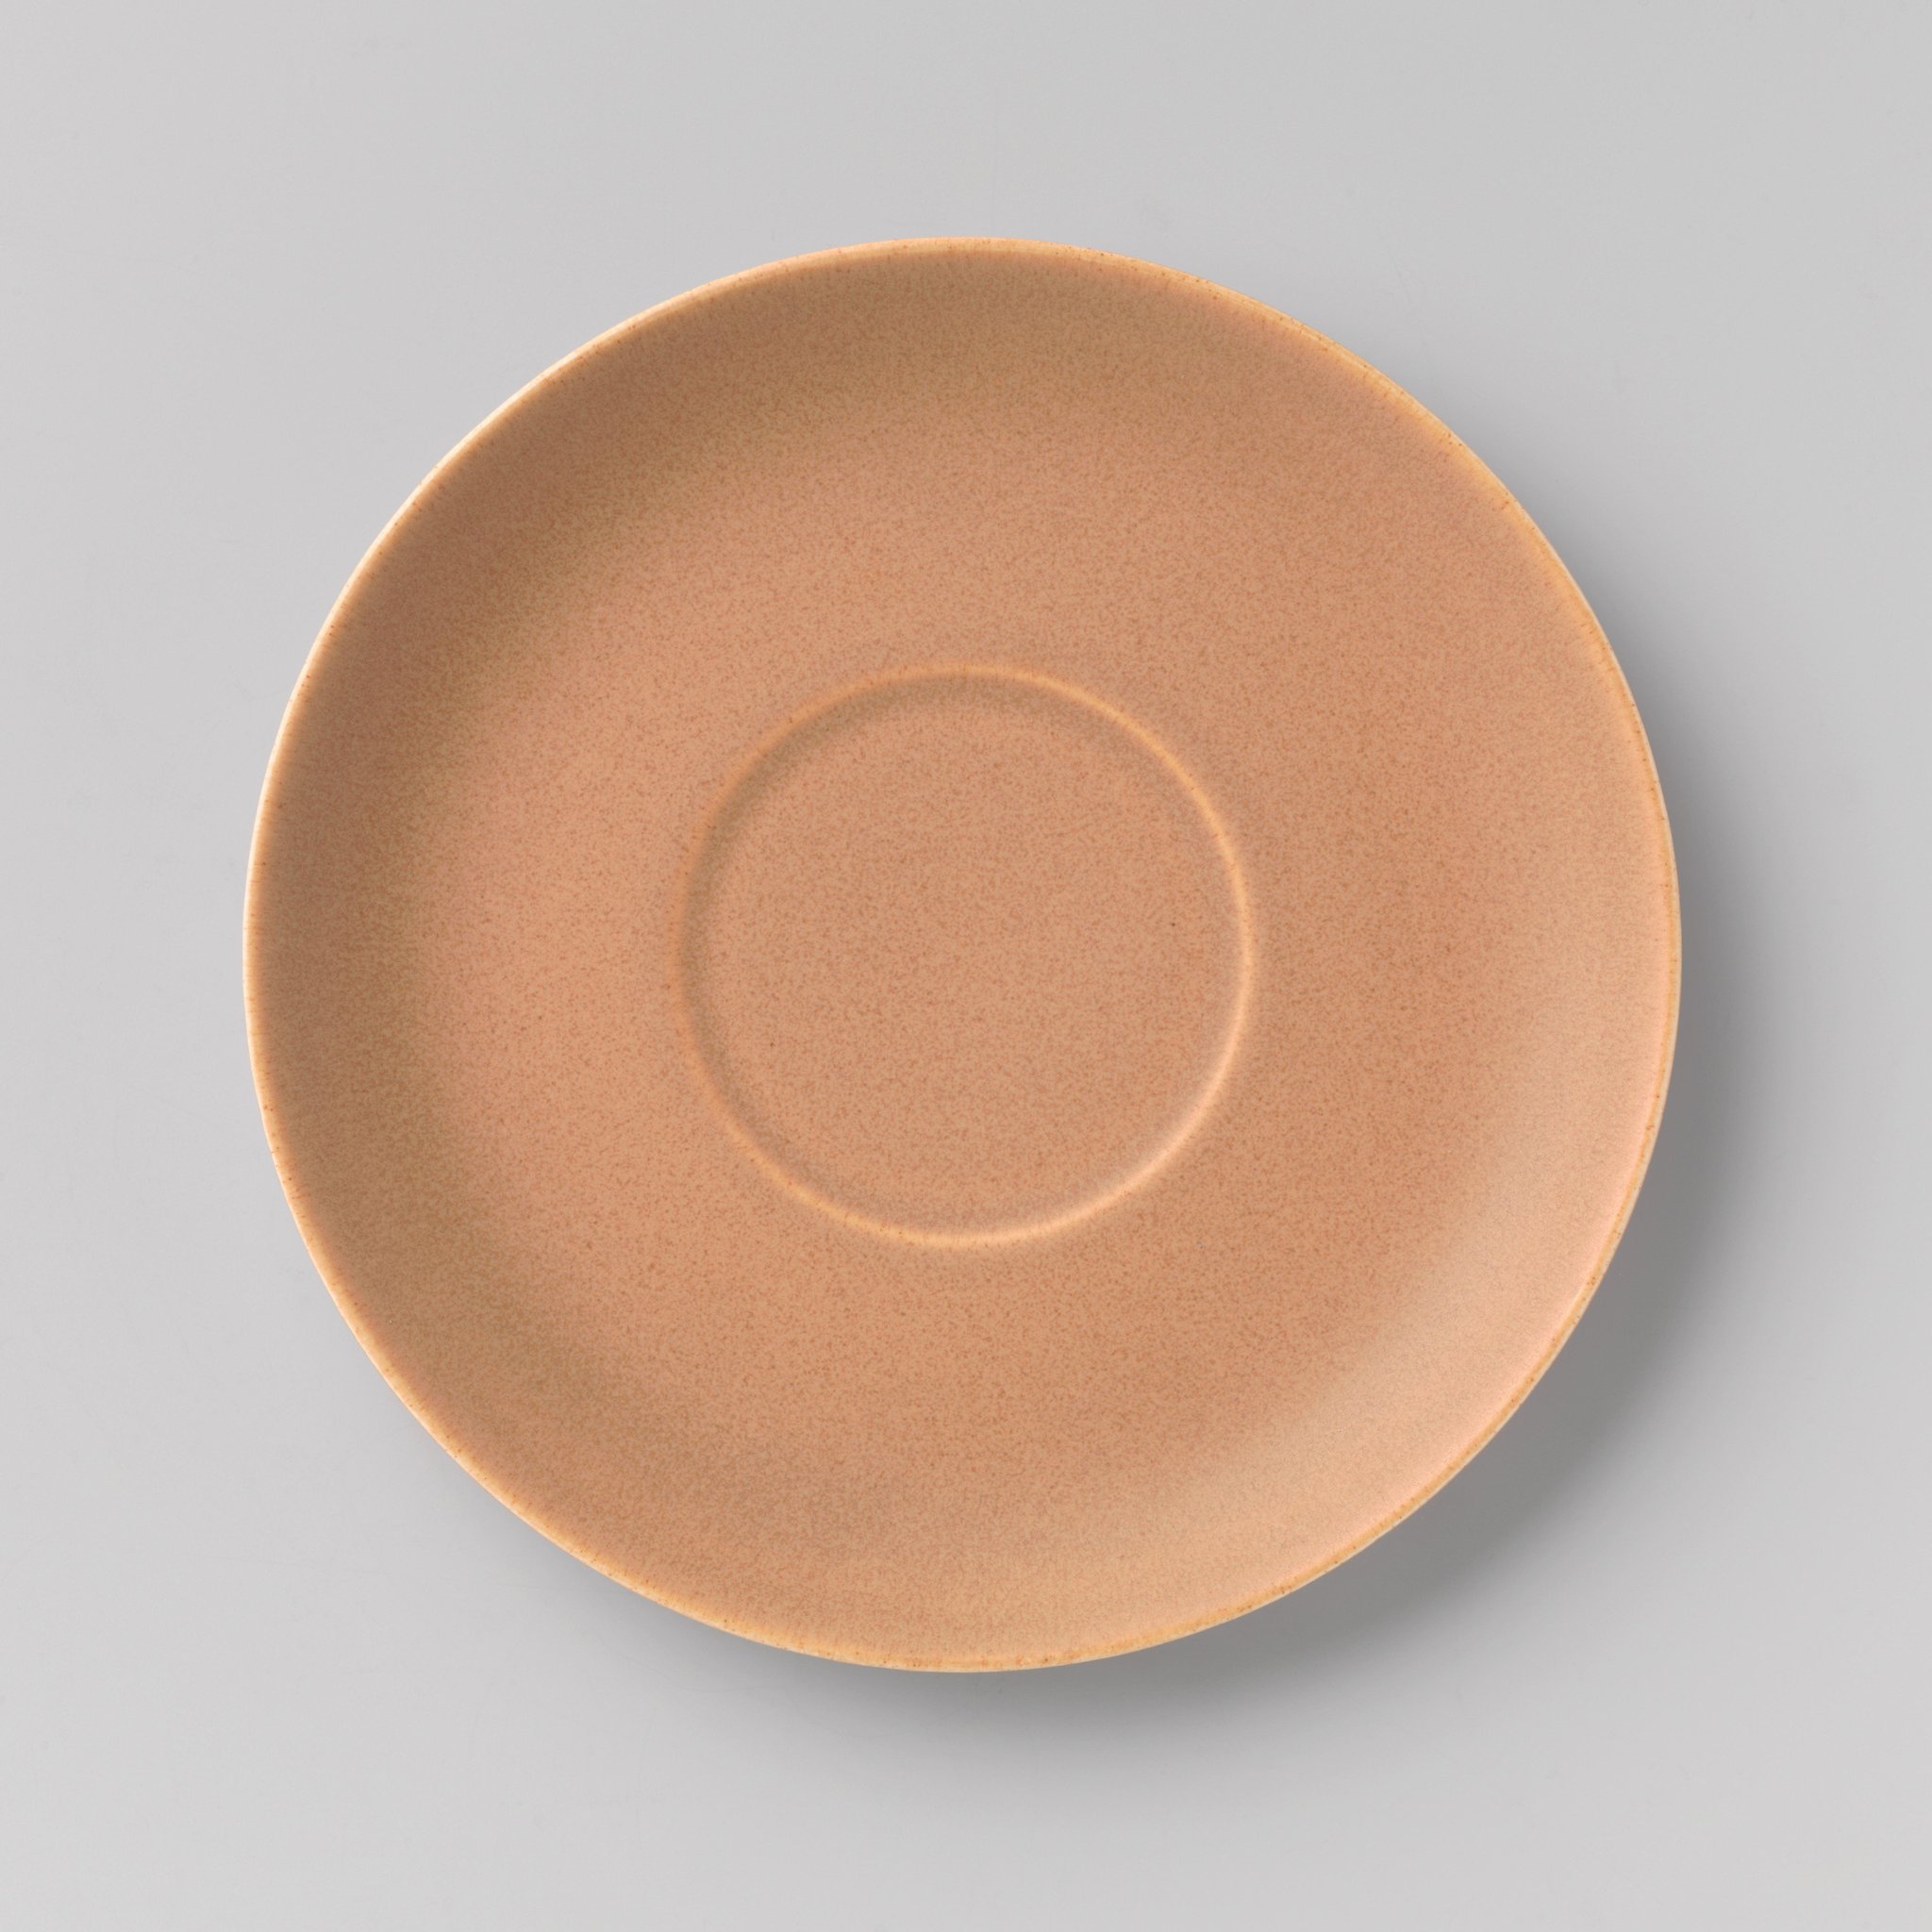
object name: platter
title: Schotel, deel van een theeservies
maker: edmond bellefroid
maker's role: ceramicist, painter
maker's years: 1893-1971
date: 1934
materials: earthenware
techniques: painted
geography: maastricht